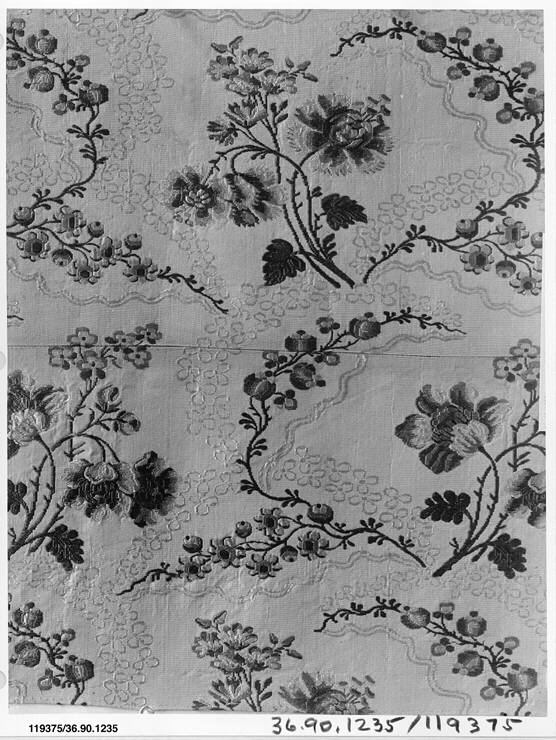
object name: piece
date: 1750-1760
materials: silk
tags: flowers,leaves